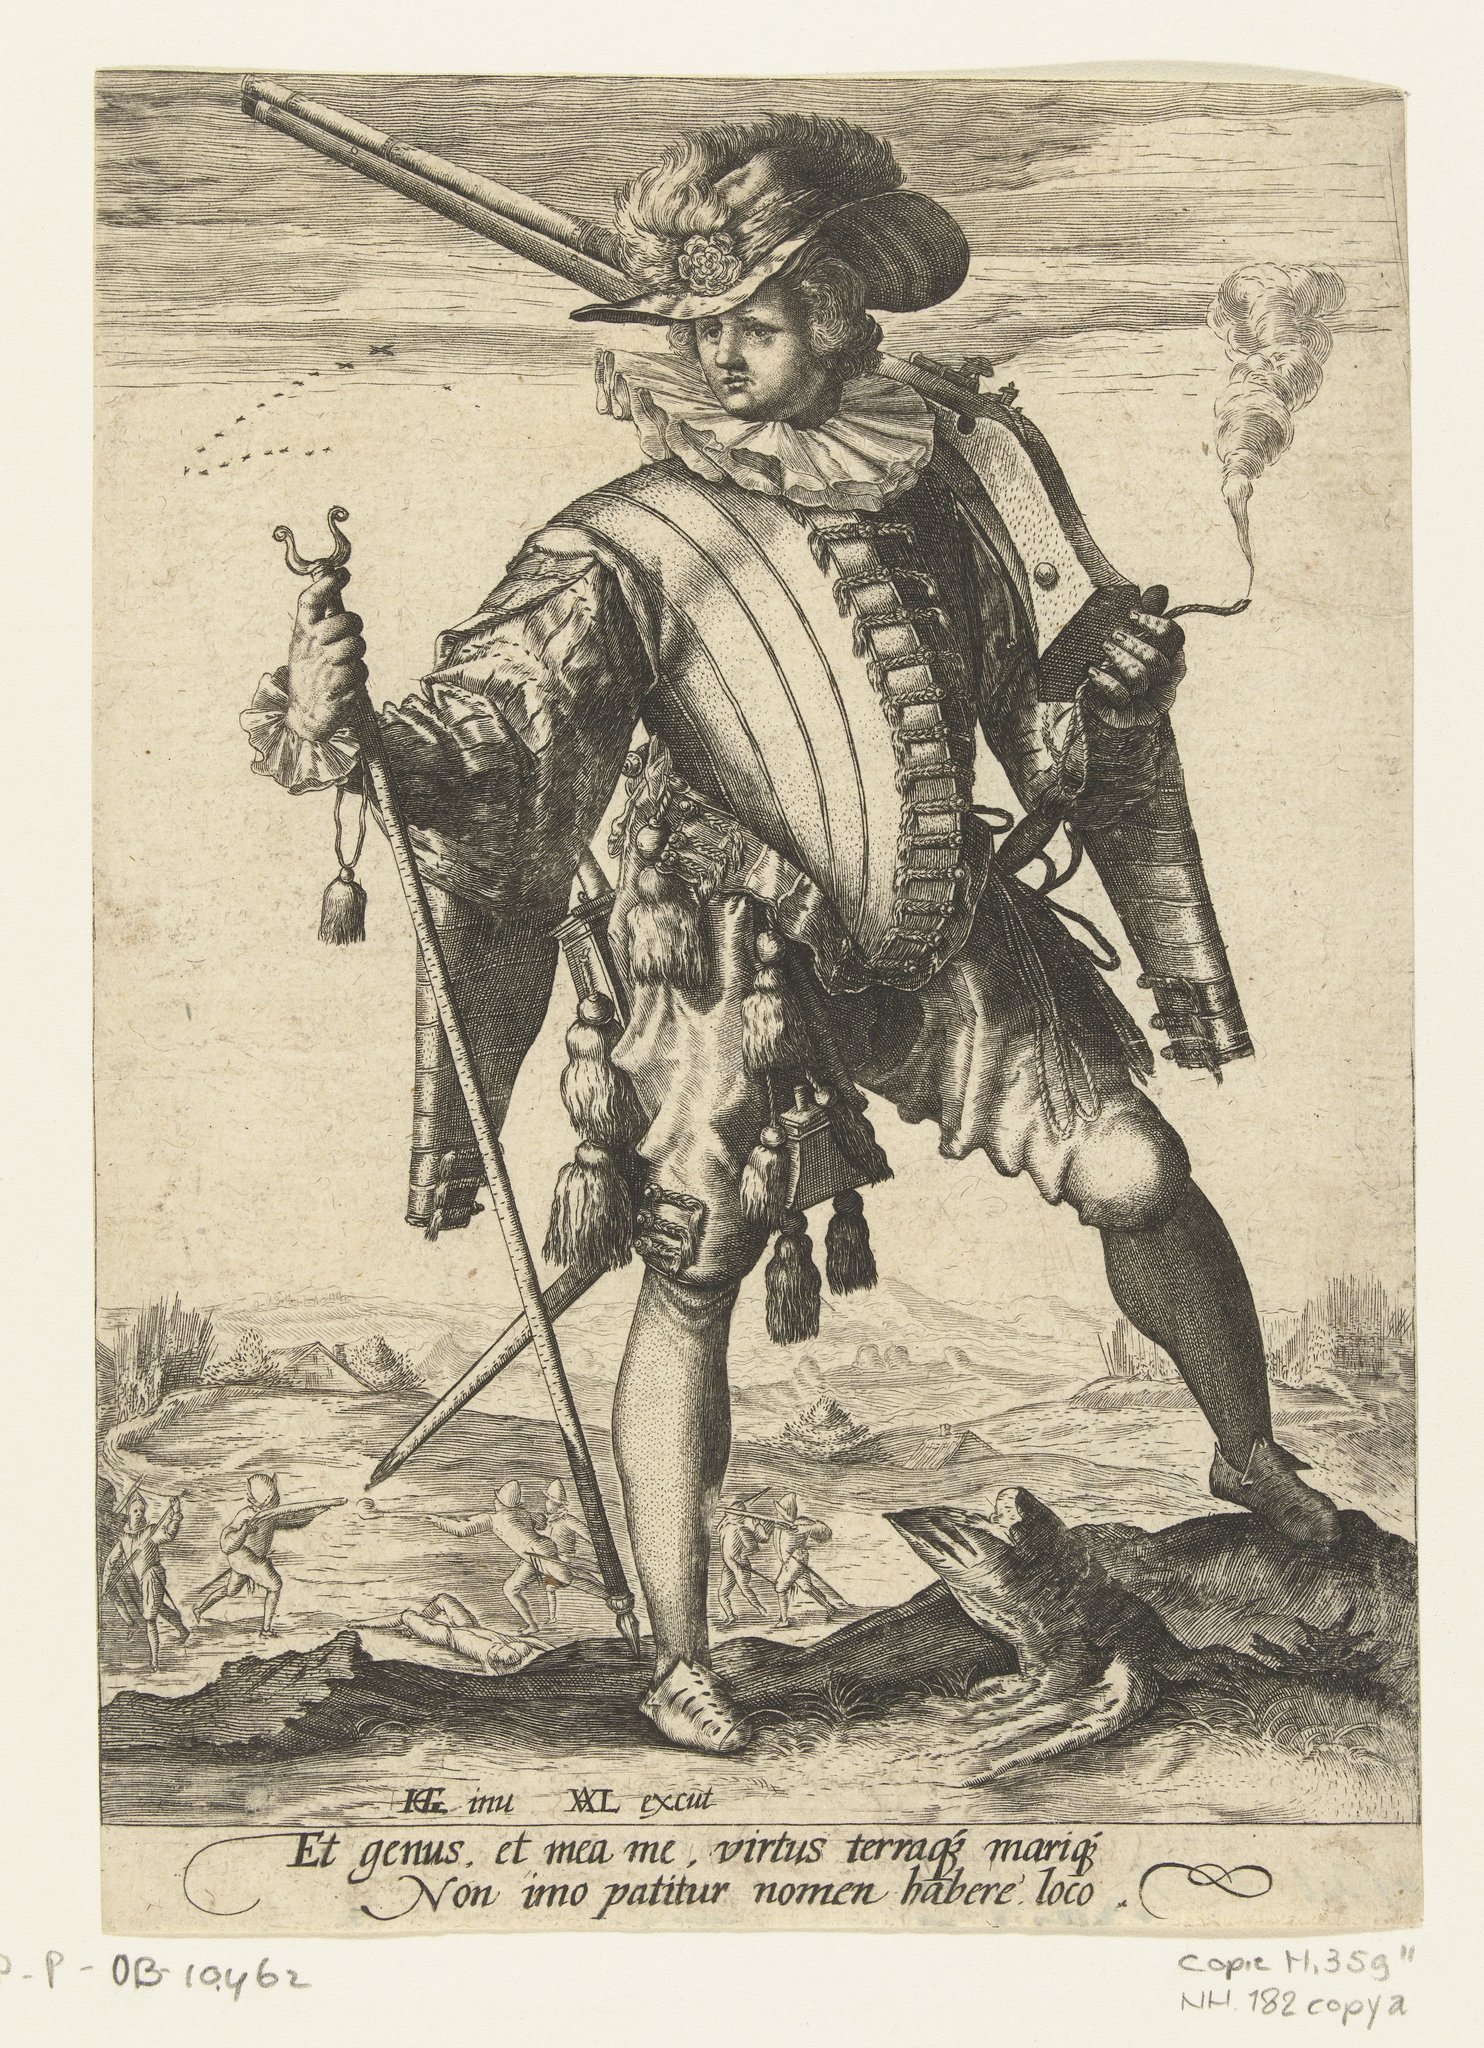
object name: print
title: Officieren en soldaten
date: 1587-1595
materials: paper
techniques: engraving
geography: netherlands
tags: private soldier, firearms: rifle, hand-to-hand fighting (~ battle)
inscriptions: collector's mark: Lugt 2228a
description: Een soldaat met een geweer (musket) en een brandende lont in de linkerhand en een furketstok in de rechterhand, ten voeten uit. Op de achtergrond een heuvelachtig landschap waarin soldaten elkaar beschieten. Onder de voorstelling twee regels tekst in Latijn. Deze prent is onderdeel van een serie van 12 prenten van militairen, ten voeten uit weergegeven tegen een landschappelijke achtergrond waarin krijgshandelingen verricht worden, en met een tweeregelig Latijns onderschrift.